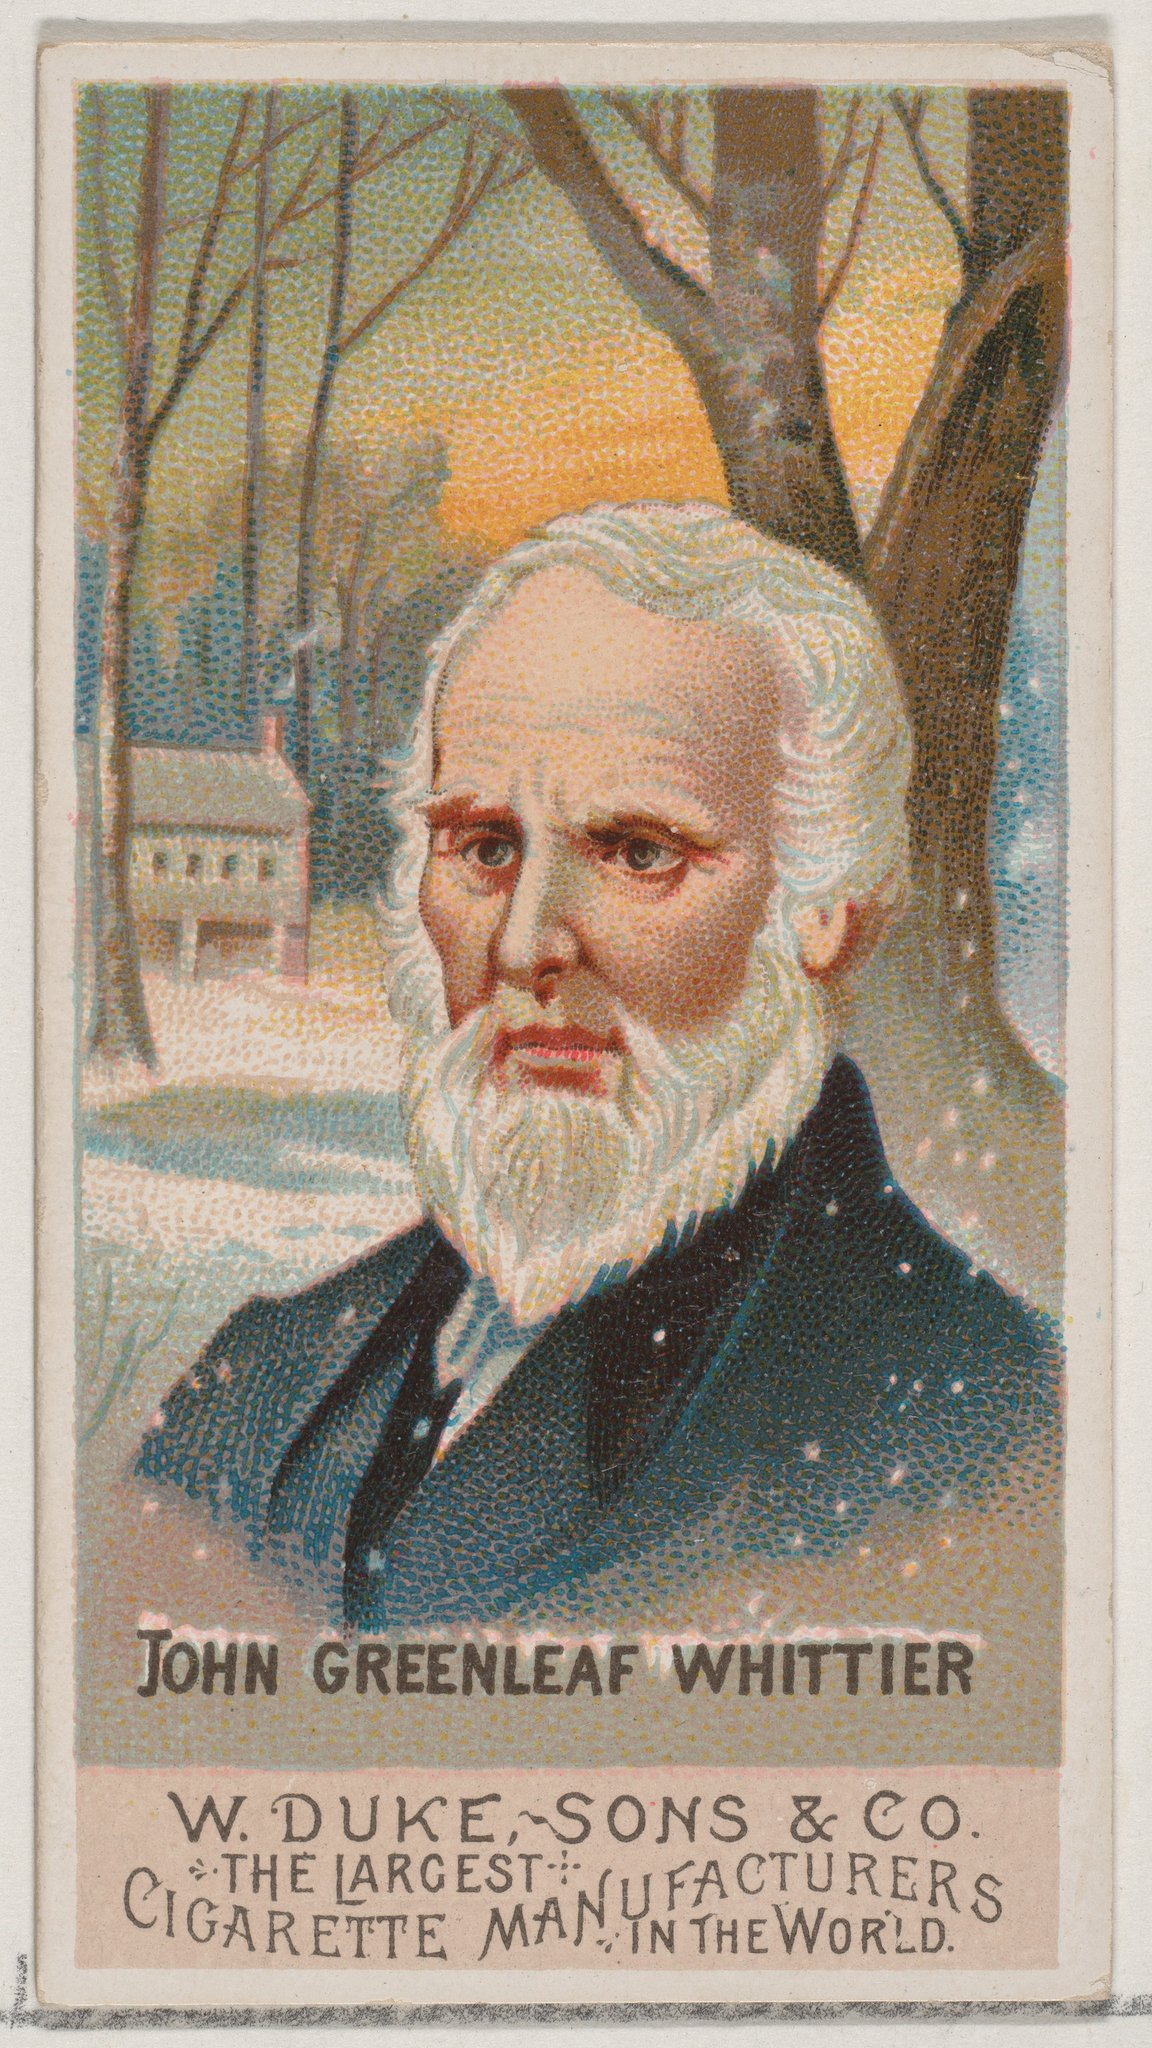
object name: print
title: John Greenleaf Whittier, from the series Great Americans (N76) for Duke brand cigarettes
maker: w. duke, sons & co.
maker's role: publisher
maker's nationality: american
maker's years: 1870-1920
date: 1888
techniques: color lithograph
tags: men